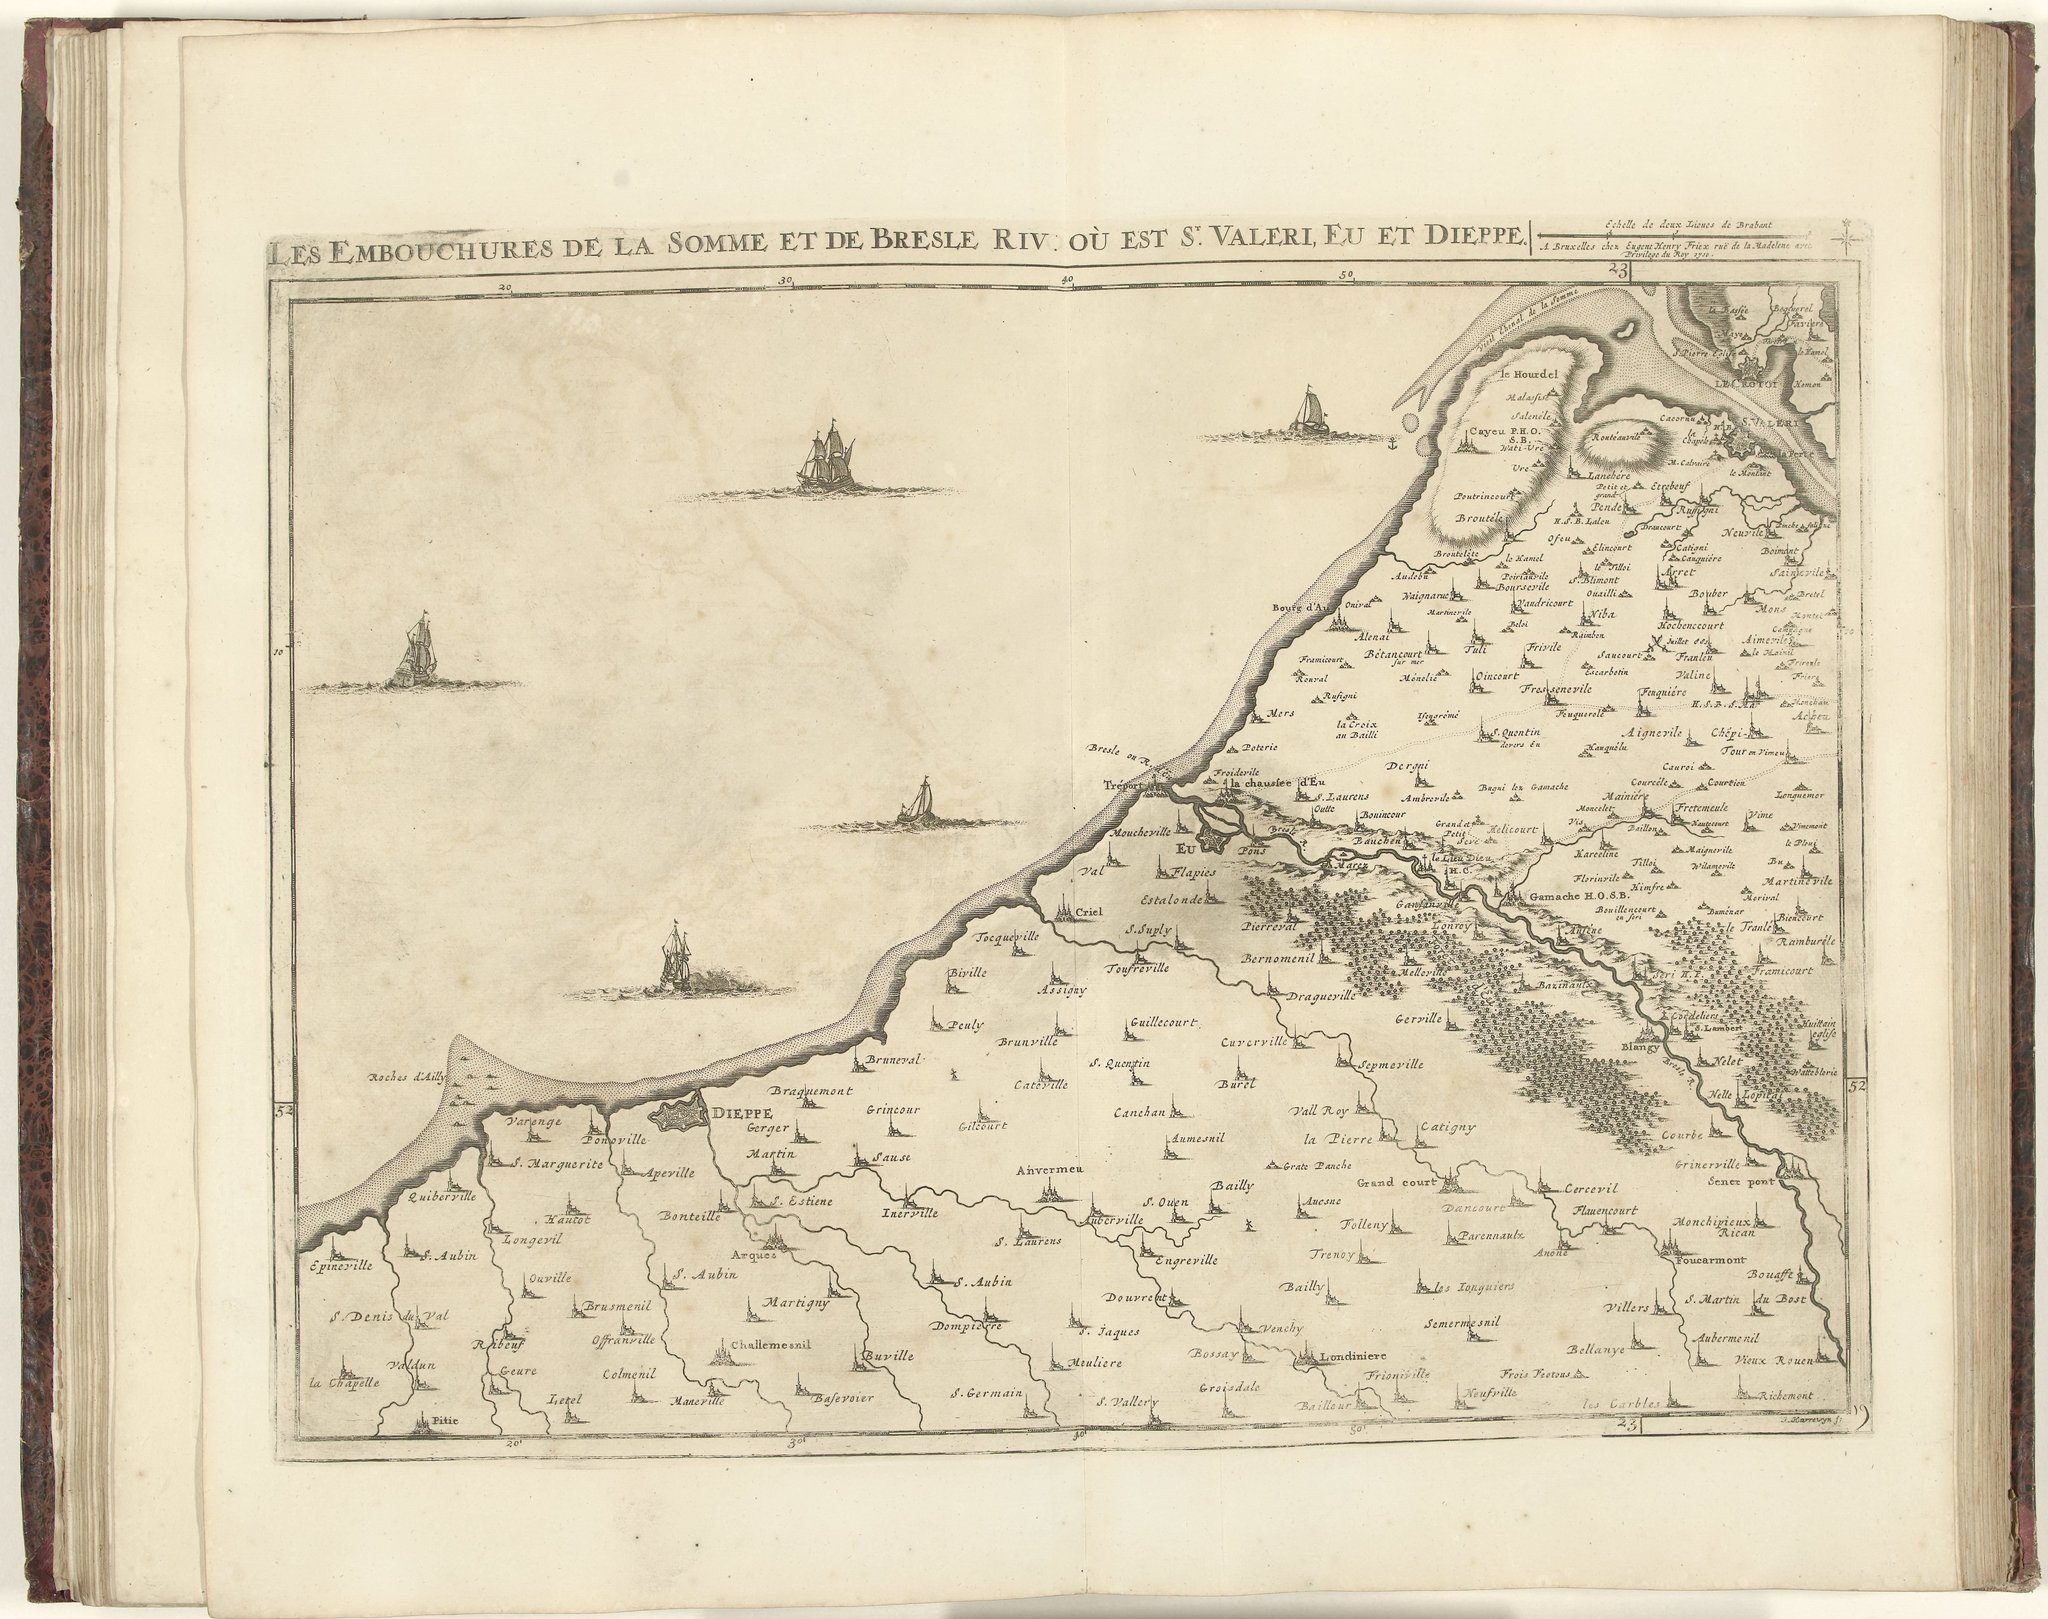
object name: print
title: Kaart van de kust van Noord-Frankrijk met de mondingen van de Somme en de Bresle, 1710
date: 1710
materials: paper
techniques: engraving, etching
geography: brussels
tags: maps of separate countries or regions, northern france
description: Kaart van de kust van Noord-Frankrijk met de mondingen van de rivieren de Somme en de Bresle, 1710. Onderdeel van een gebundelde verzameling van plannen van veldslagen en steden vermaard in de Spaanse Successieoorlog. Deze plaat behoort tot de eerste 24 platen die samen een zeer grote kaart van de Zuidelijke Nederlanden vormen.